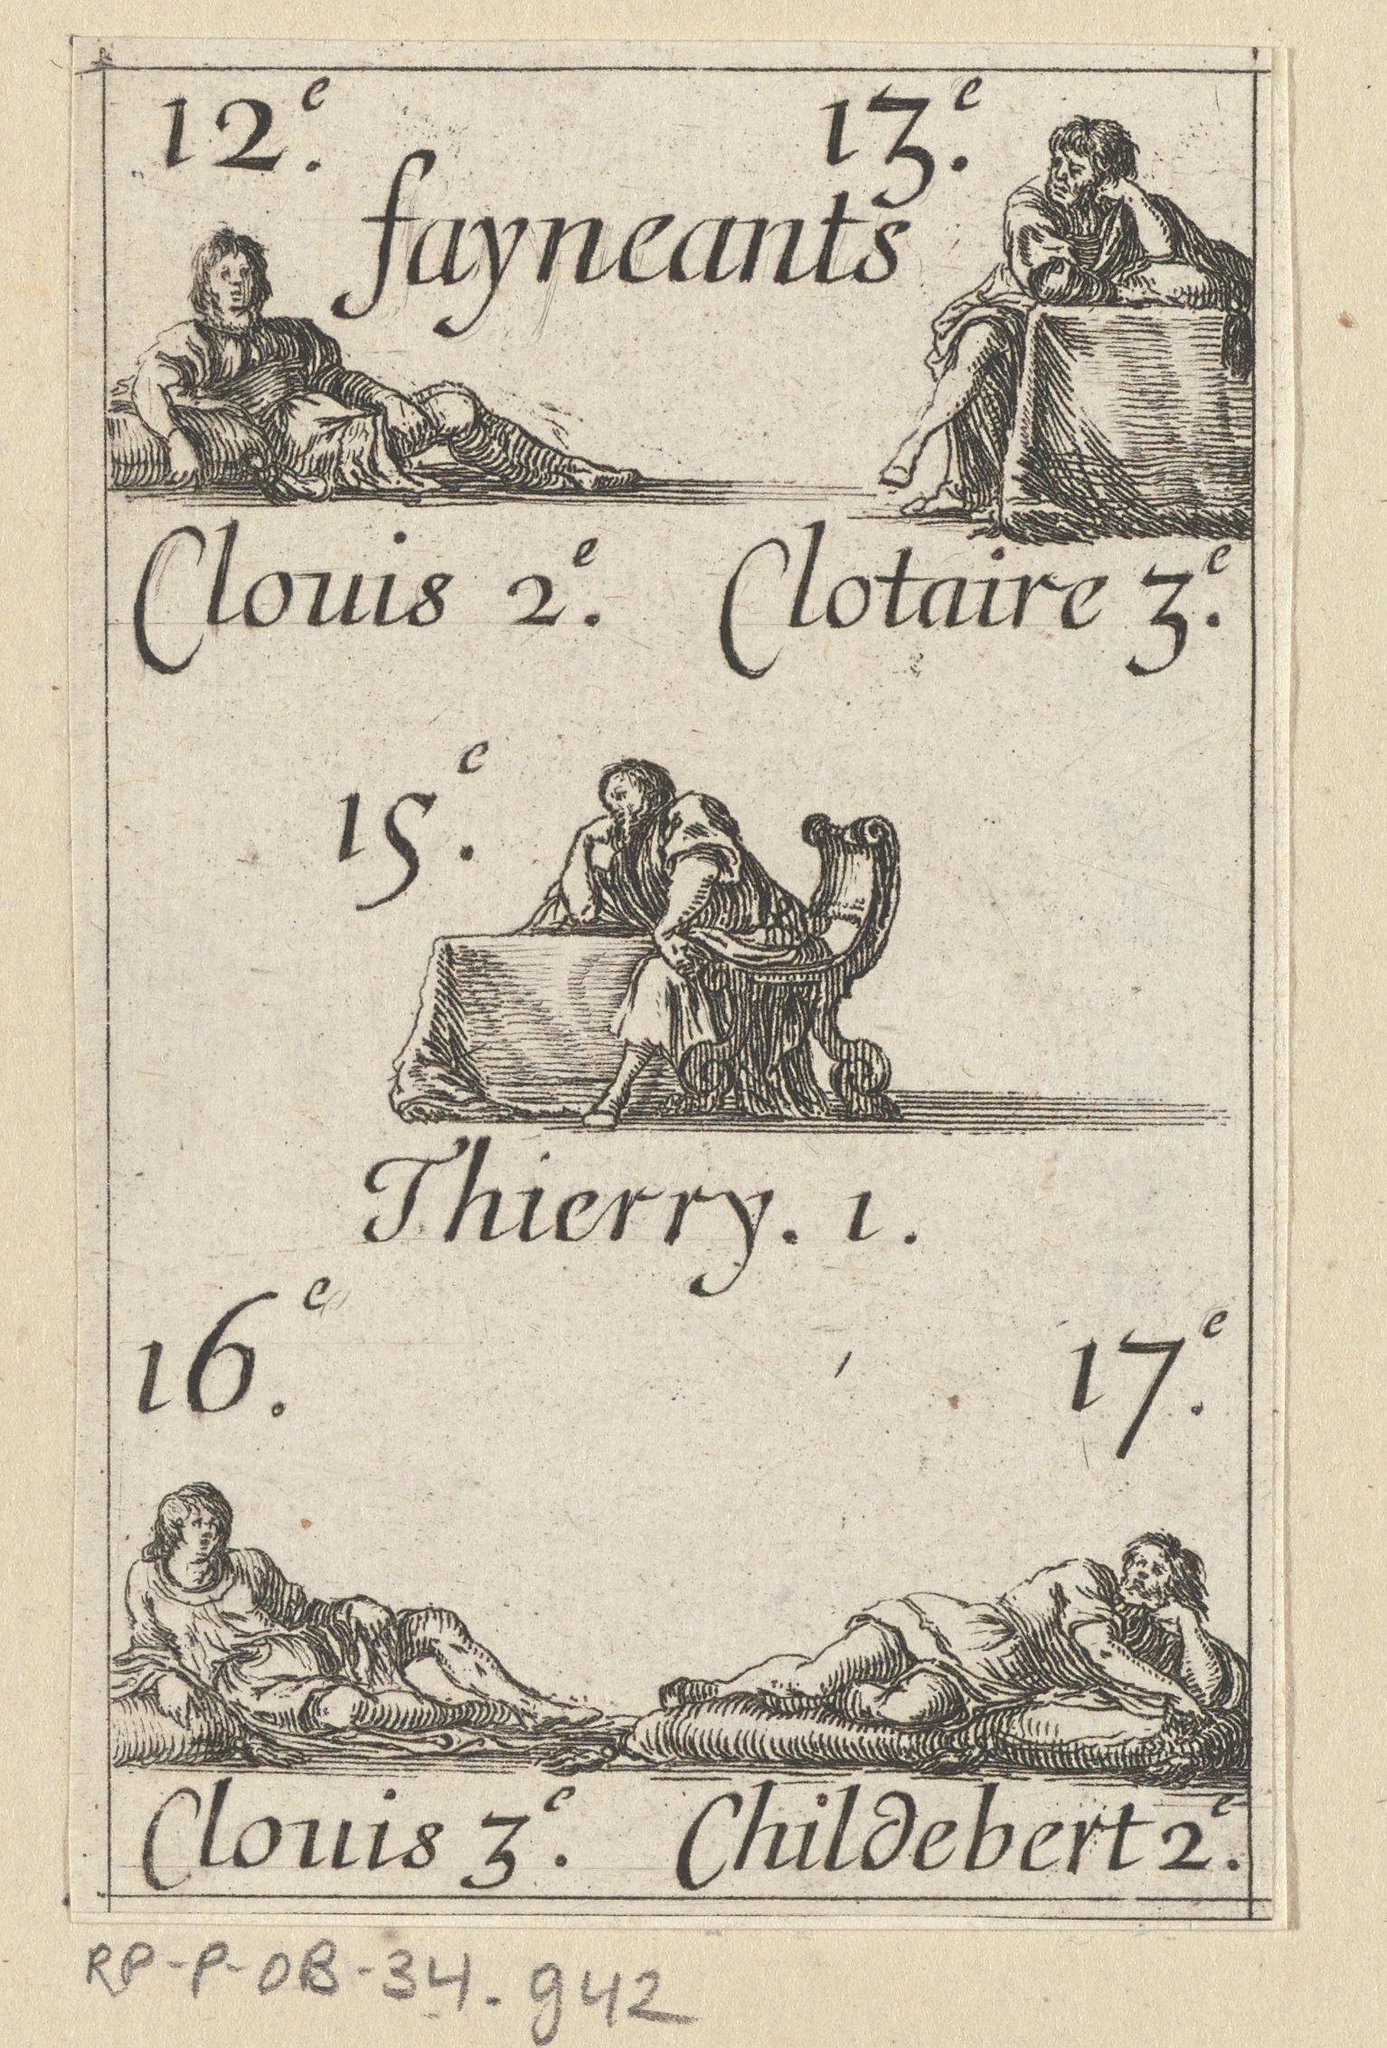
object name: playing card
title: Kaartspel met heersers van Frankrijk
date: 1620-1664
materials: paper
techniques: etching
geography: paris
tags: ruler, sovereign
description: Deze prent maakt deel uit van een kaartspel met 39 kaarten met voorstellingen van Franse koningen. De serie is uitgedacht door Jean Desmarests de Saint-Sorlin in opdracht van Kardinaal Mazarin. Het kaartspel werd gemaakt voor de jonge Lodewijk XIV, samen met het Jeu des Fables, Jeu des Reynes Renommées en Jeu de la géographie.